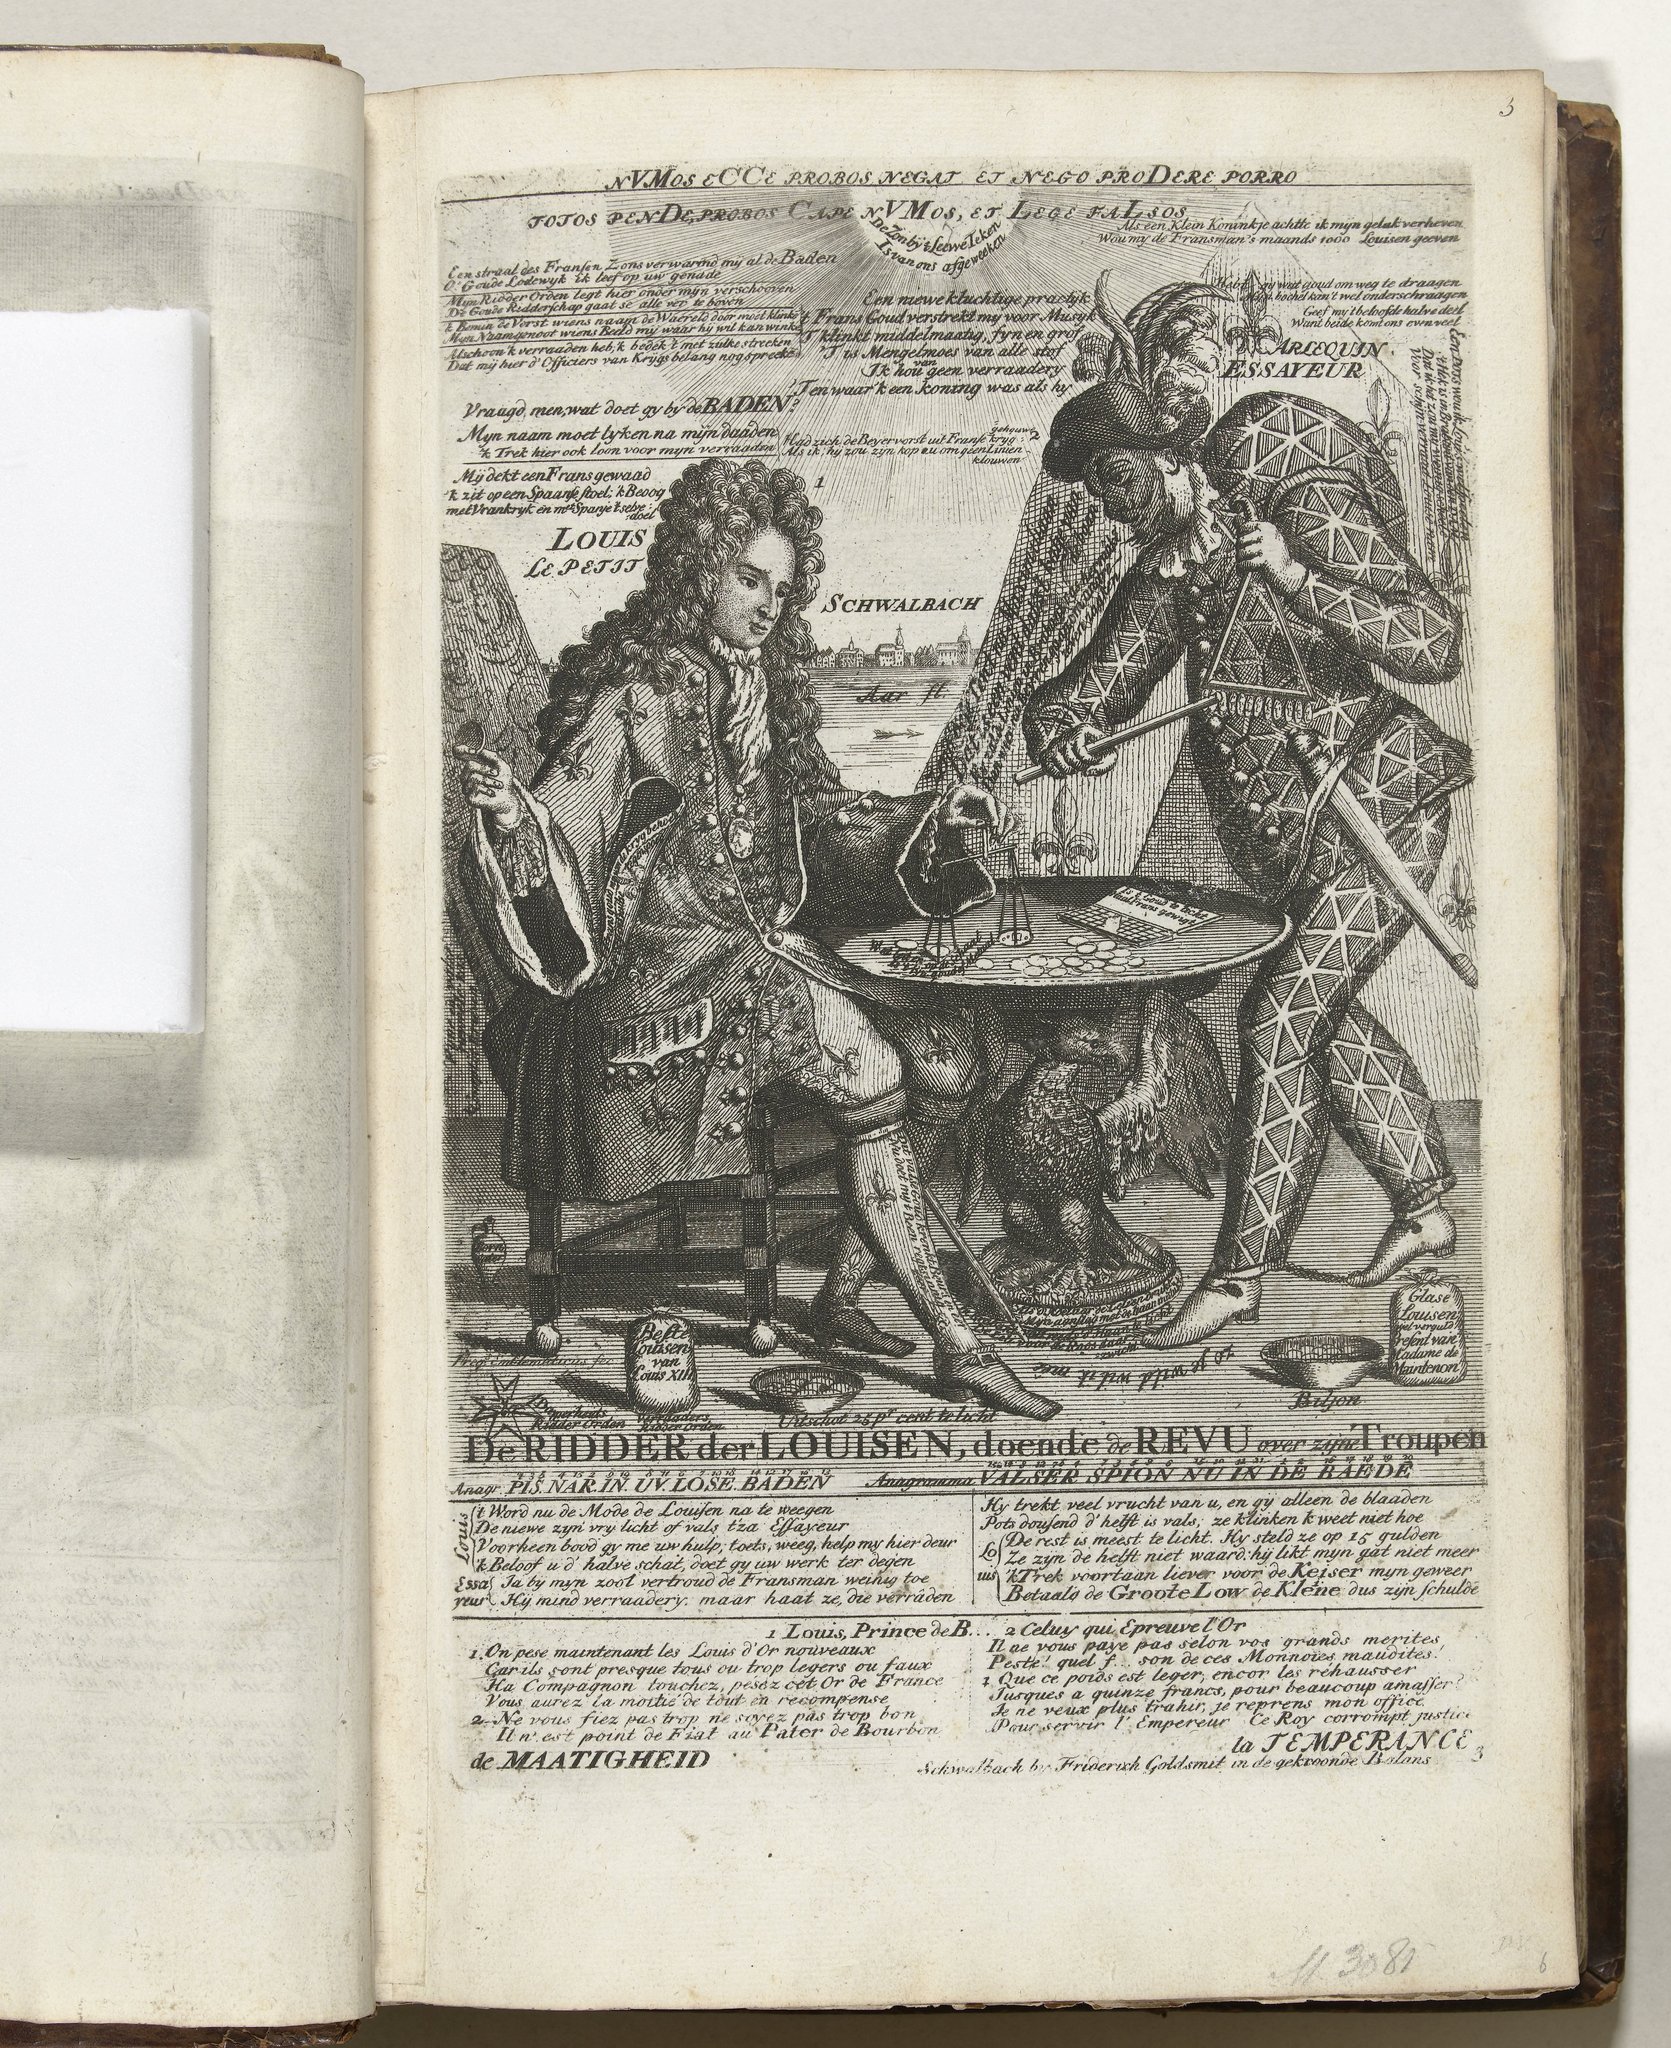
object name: print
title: De Ridder der Louisen, doende de Revu over zijne Troupen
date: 1706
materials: paper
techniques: etching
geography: amsterdam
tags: paris, weighing gold or money, types in 'commedia dell'arte': harlequin, political caricatures and satires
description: Harlekijn (koning Lodewijk XIV) met triangel en bochel komt Lodewijk Willem, markgraaf van Baden-Baden, die geld aan het wegen is, overreden over te lopen naar Franse zijde. Met verzen in het Nederlands en Frans in de plaat. Prent nr. 3 (de Maatigheid - la Temperance) in de serie van 7 prenten in de Koninklyke Almanach van 1705 in het prentwerk uitgegeven onder de verzameltitel 't Lust-Hof van Momus met de gebundelde series van spotprenten tijdens de jaren 1701-1713 van de Spaanse Successieoorlog.